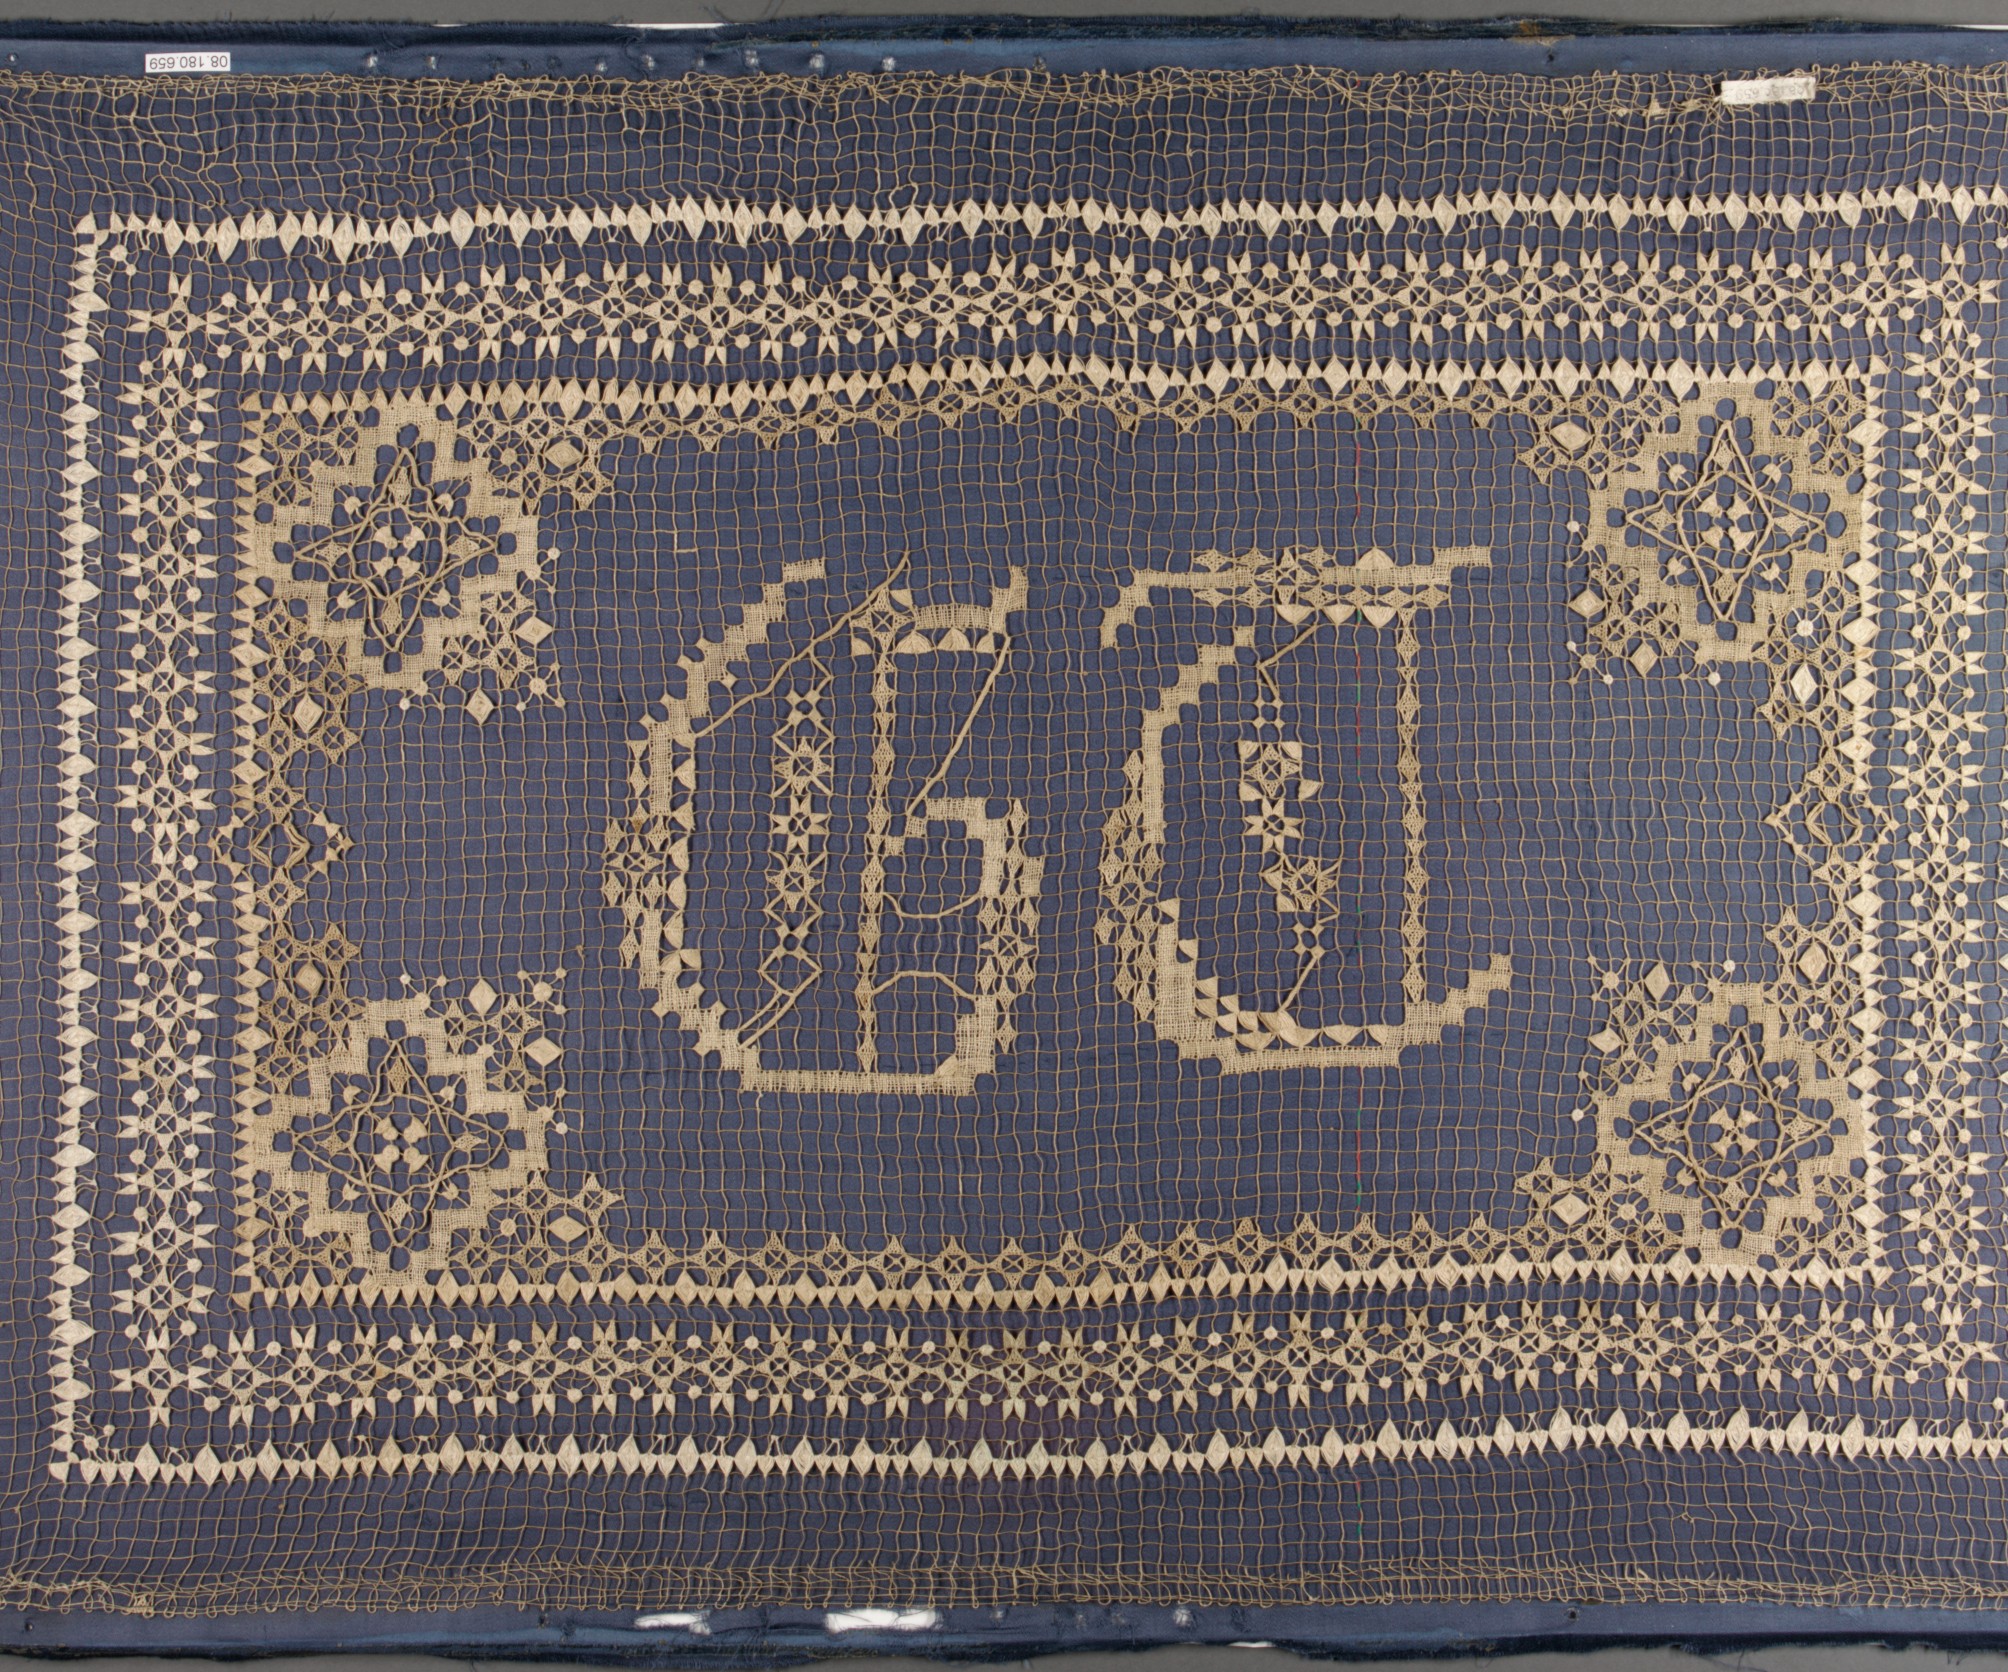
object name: cover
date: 1801-1900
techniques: embroidery